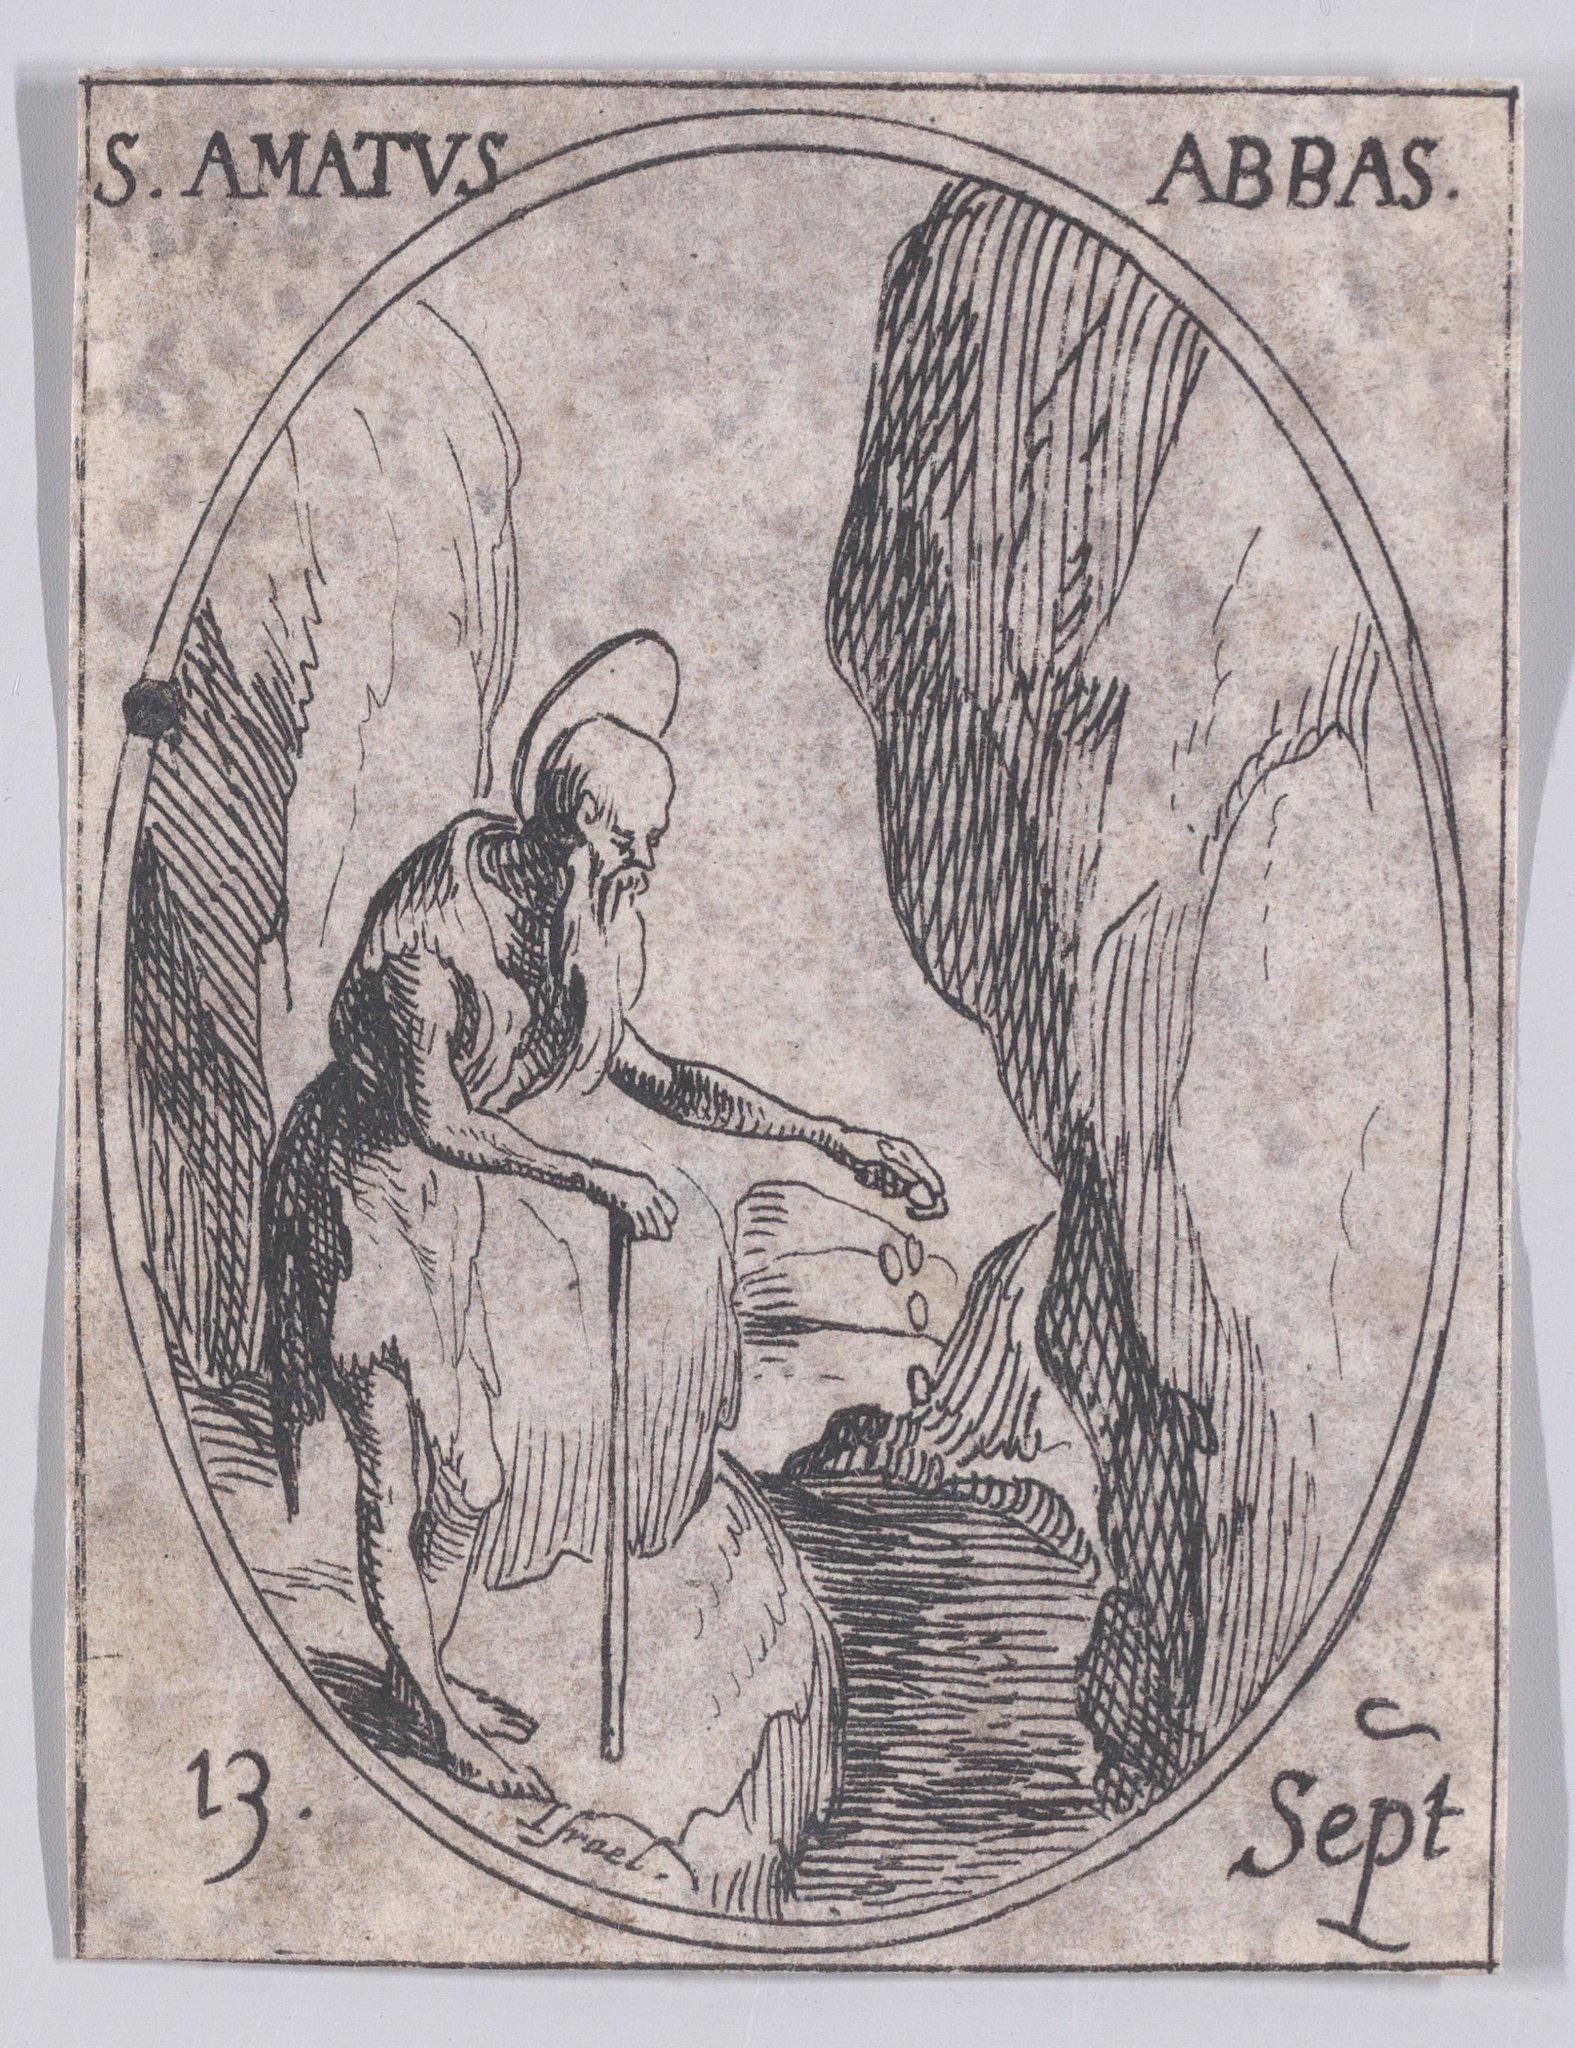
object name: print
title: S. Amé, abbé (St. Amatus, Abbot), September 13th, from "Les Images De Tous Les Saincts et Saintes de L'Année" (Images of All of the Saints and Religious Events of the Year)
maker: jacques callot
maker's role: artist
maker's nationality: french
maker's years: 1592-1635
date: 1636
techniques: etching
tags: men,saints